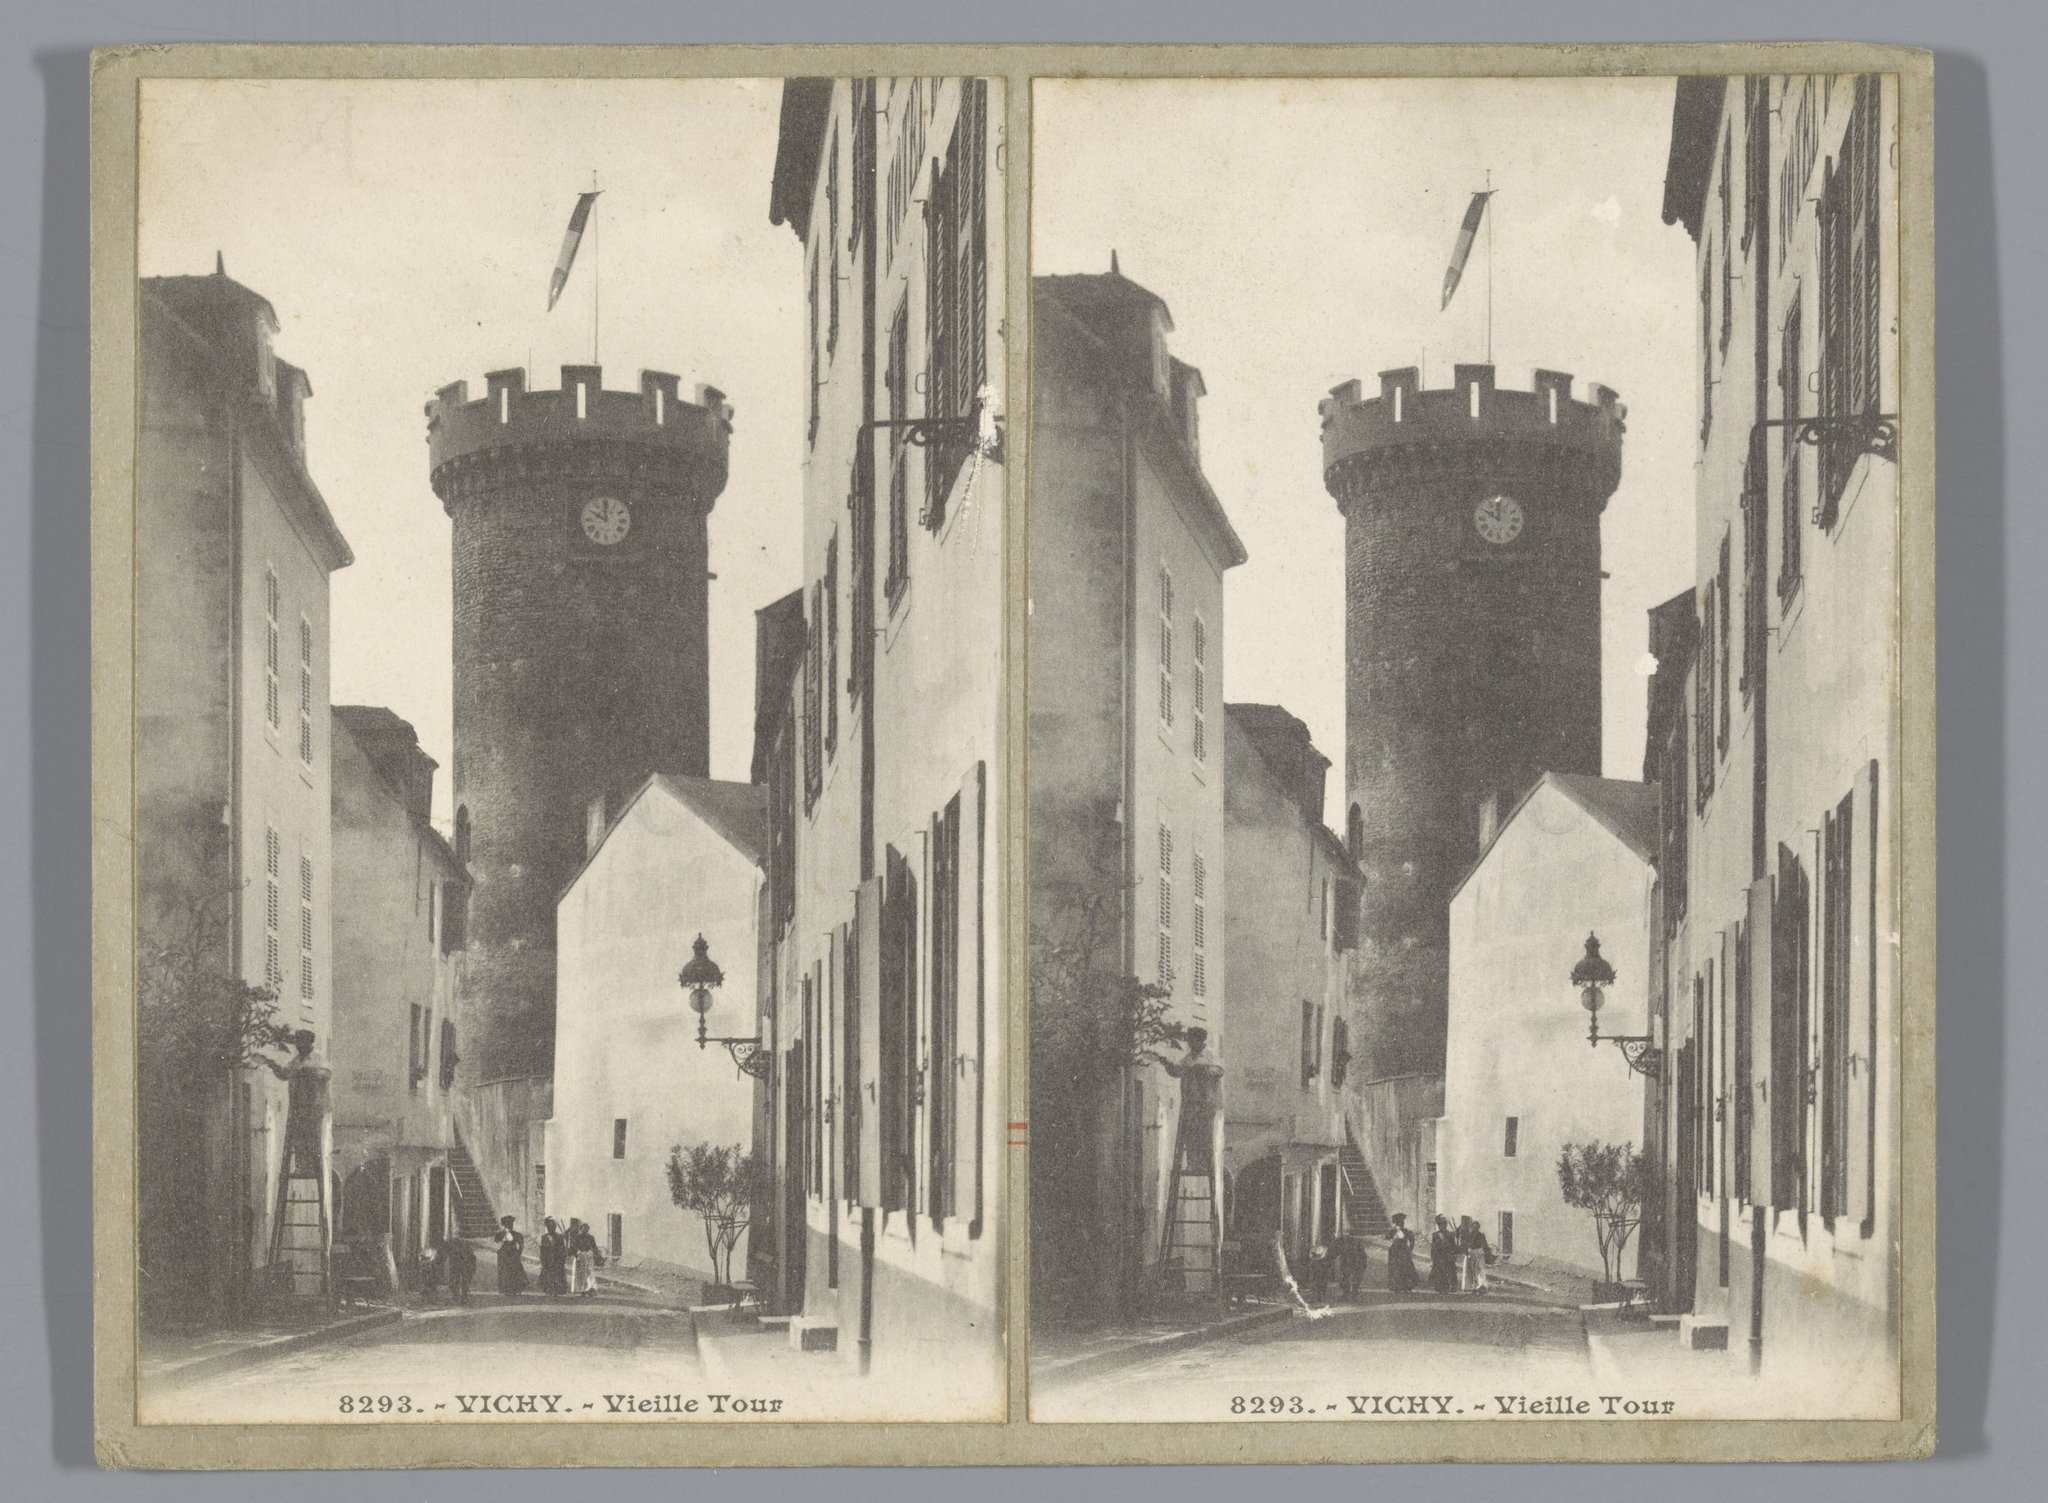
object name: stereograph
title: Vichy.-Vieille Tour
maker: Anonymous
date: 1890-1910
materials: cardboard, paper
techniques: photograph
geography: vichy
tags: tower, clock tower ~ monumental adornment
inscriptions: number: ‘8293.’